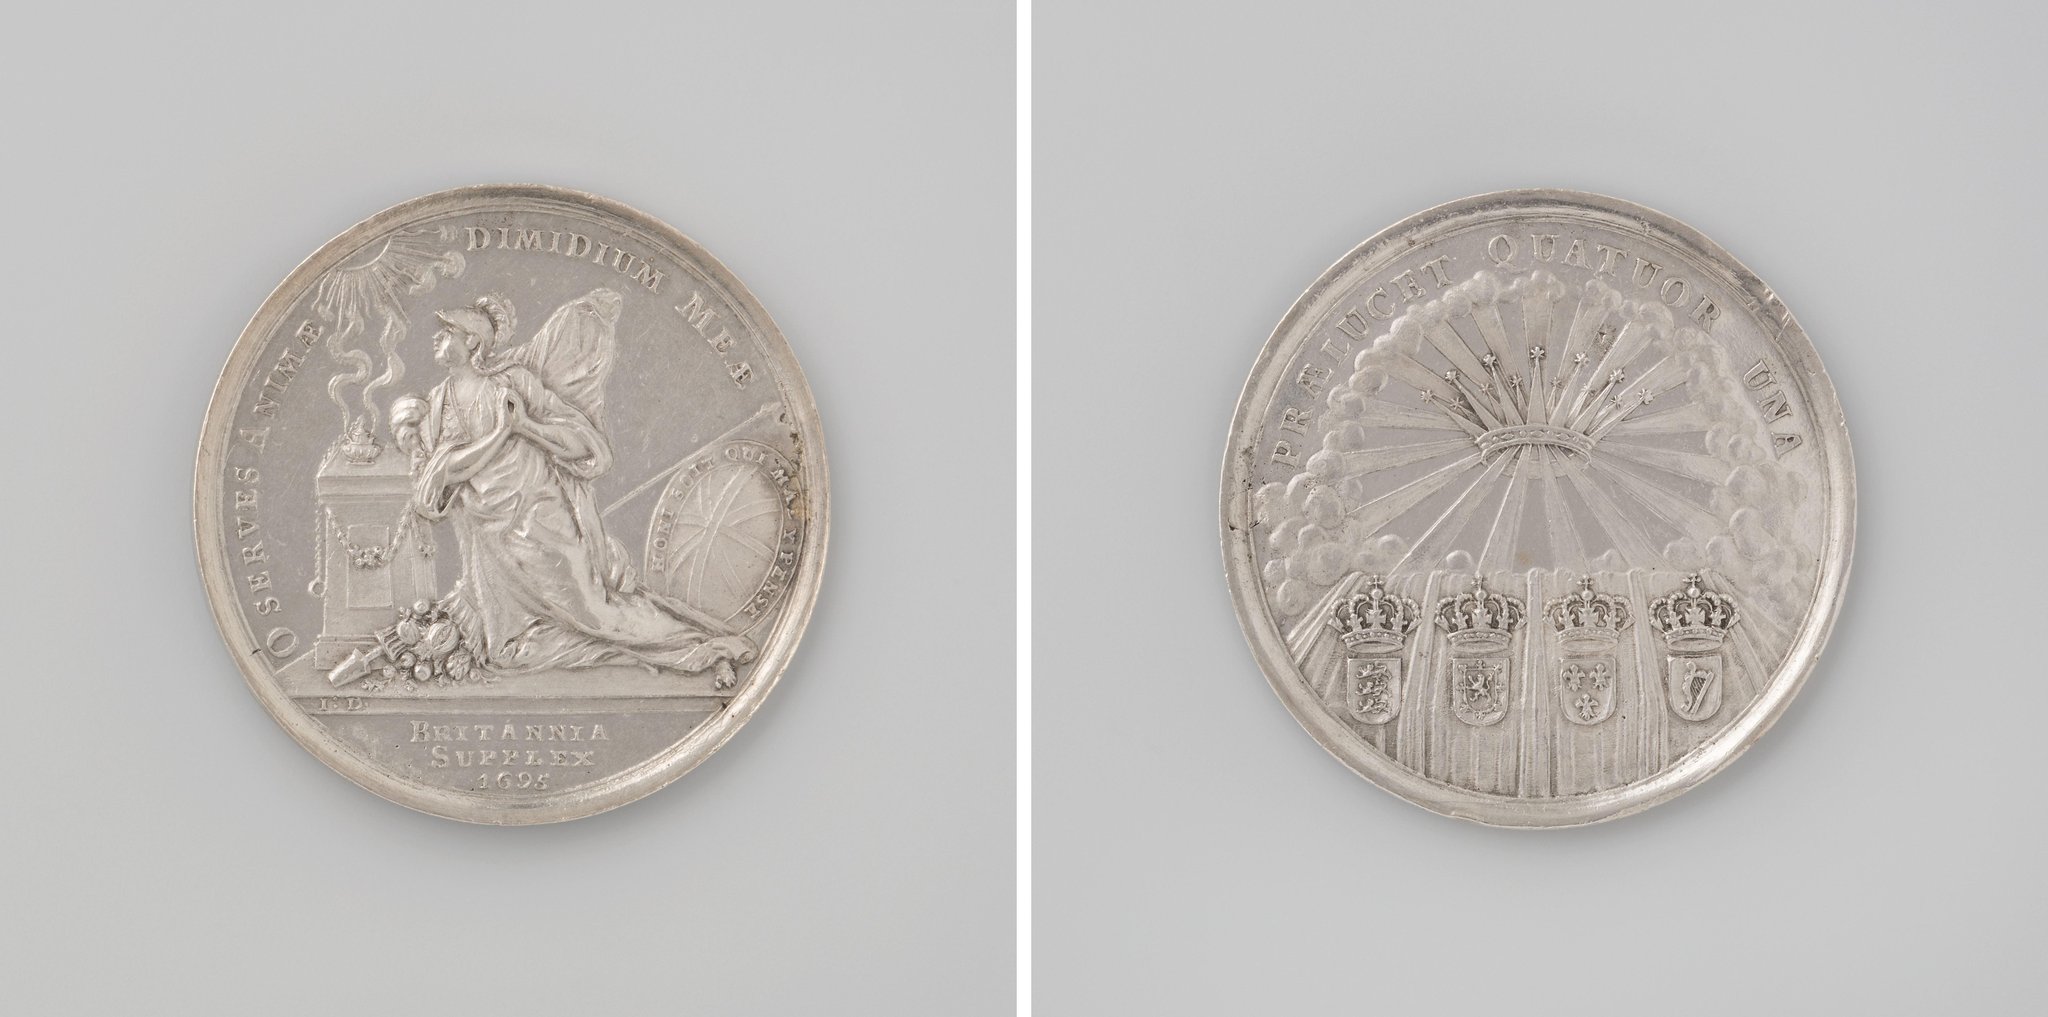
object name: history medal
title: Overlijden van Maria II van Engeland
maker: johannes drappentier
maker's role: die cutter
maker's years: 1689-1758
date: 1695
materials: silver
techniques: striking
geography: dordrecht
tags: london, maria ii stuart (koningin van engeland, schotland en ierland), england